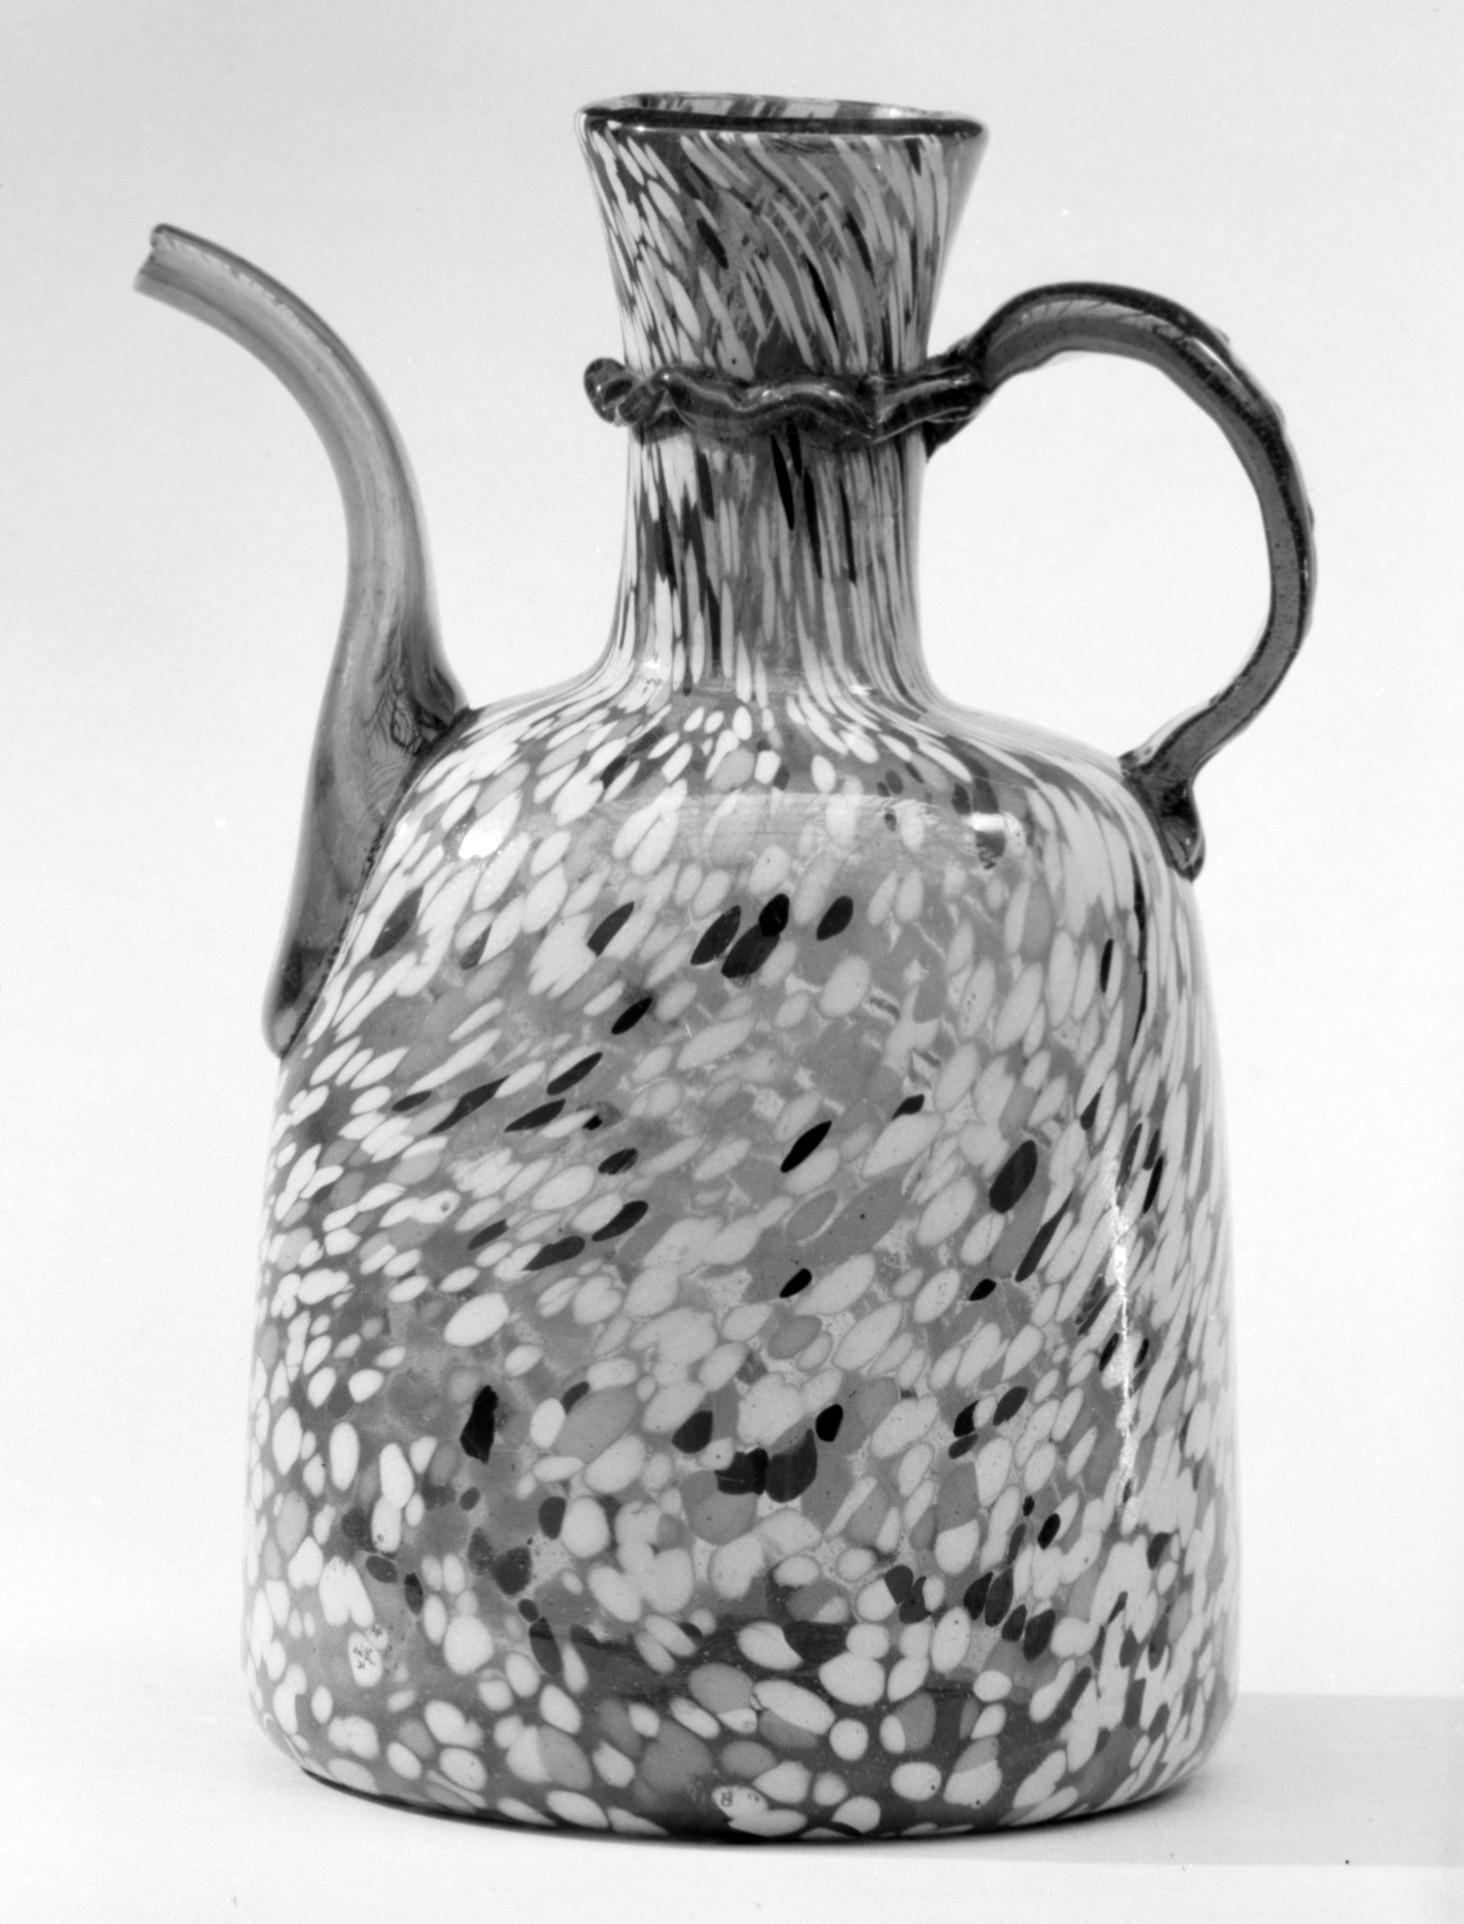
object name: ewer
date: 1601-1633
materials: glass